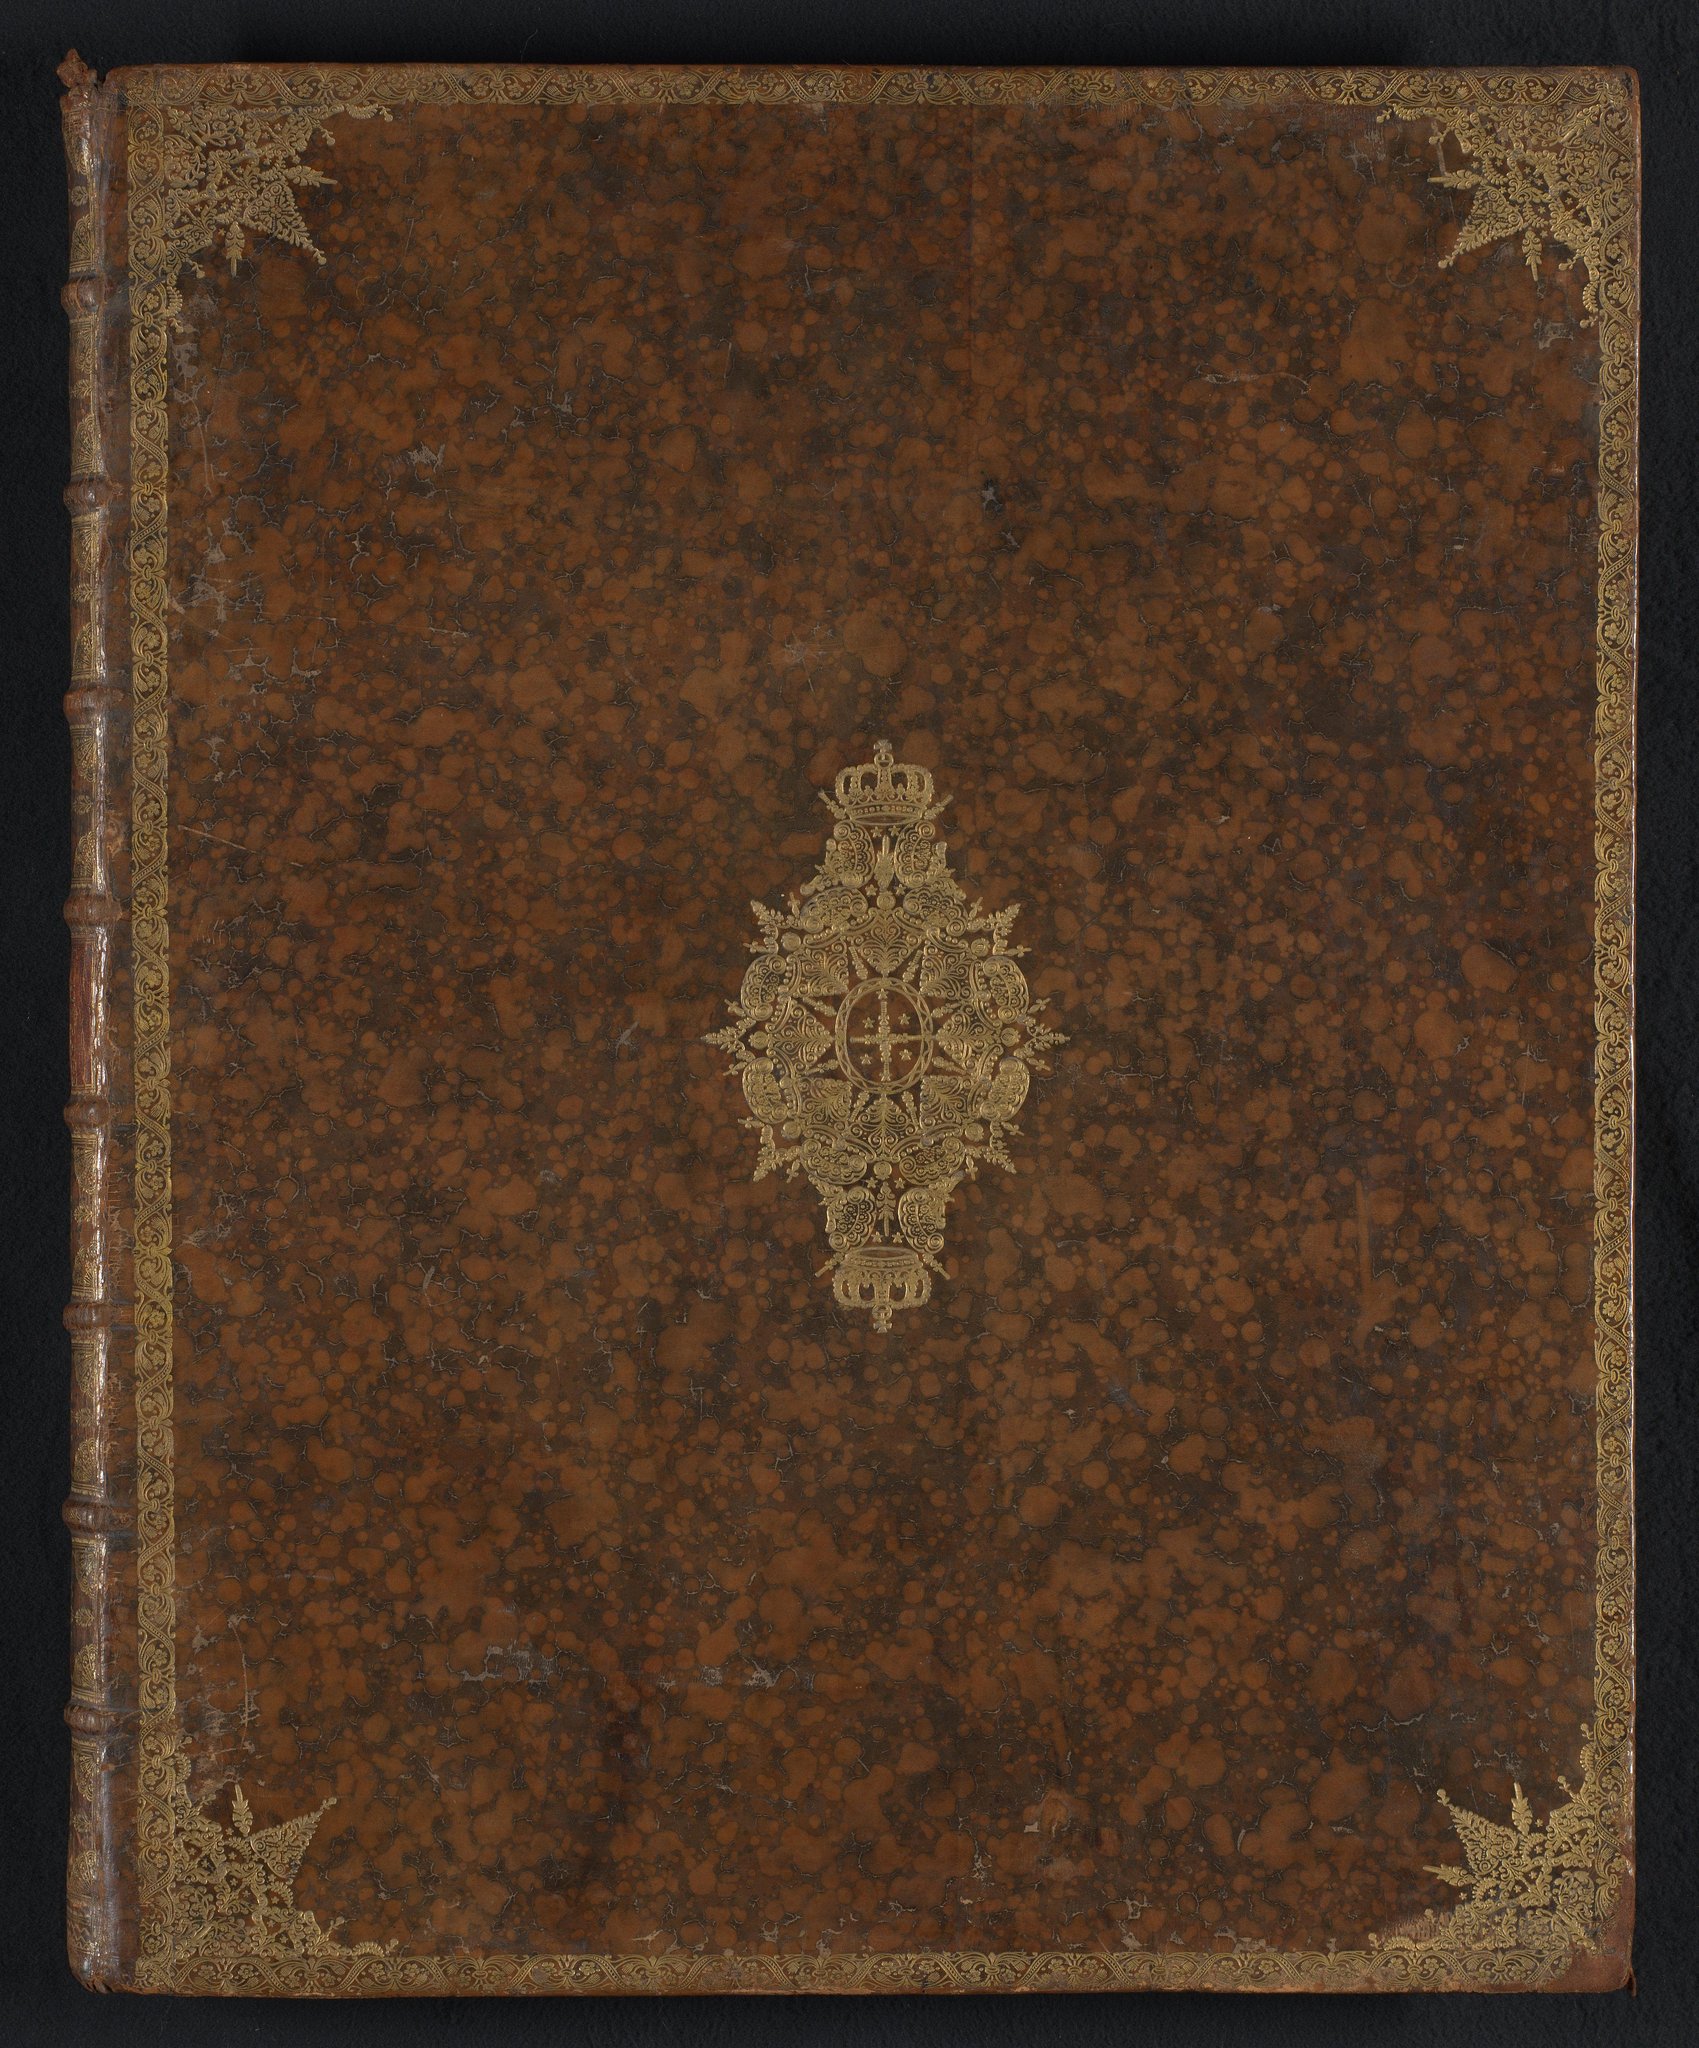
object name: prentrecueil, prentenalbum, prentalbum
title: L'ouvrage de C. le Brun Tom VII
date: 1740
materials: leather, gold leaf, paper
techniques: bookbinding, printing, marbled paper, engraving, etching, marbling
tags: print, e.g.: engraving, etching, lithograph, book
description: Er zijn geen andere exemplaren van deze samenstelling van prenten gesignaleerd. Ook gezien de verschillende technieken waarmee de prenten in dit album verwerkt zijn, is het vermoeden aanwezig dat dit een persoonlijk samengestelde albumreeks is. De datering van het album is gebaseerd op het jaartal op de titelprent. Aangezien veel van de prenten eerder gemaakt zijn, zullen die jaartallen gespecificeerd worden in de bijbehorende deelrecords. De datering van de albums wordt ondersteund door de werkzame periode van de boekbinder die de collectie gebonden heeft. Deze set albums is gebonden door wat bekend staat als de 'Pentateuch Binderij' uit Amsterdam, actief ca. 1730-1777 (zie: Storm van Leeuwen, Jan. Dutch decorated bookbinding in the eighteenth century. 3 dln. 't Goy-Houten: HES & De Graaf, 2006, dl. 1, p. 410-435).